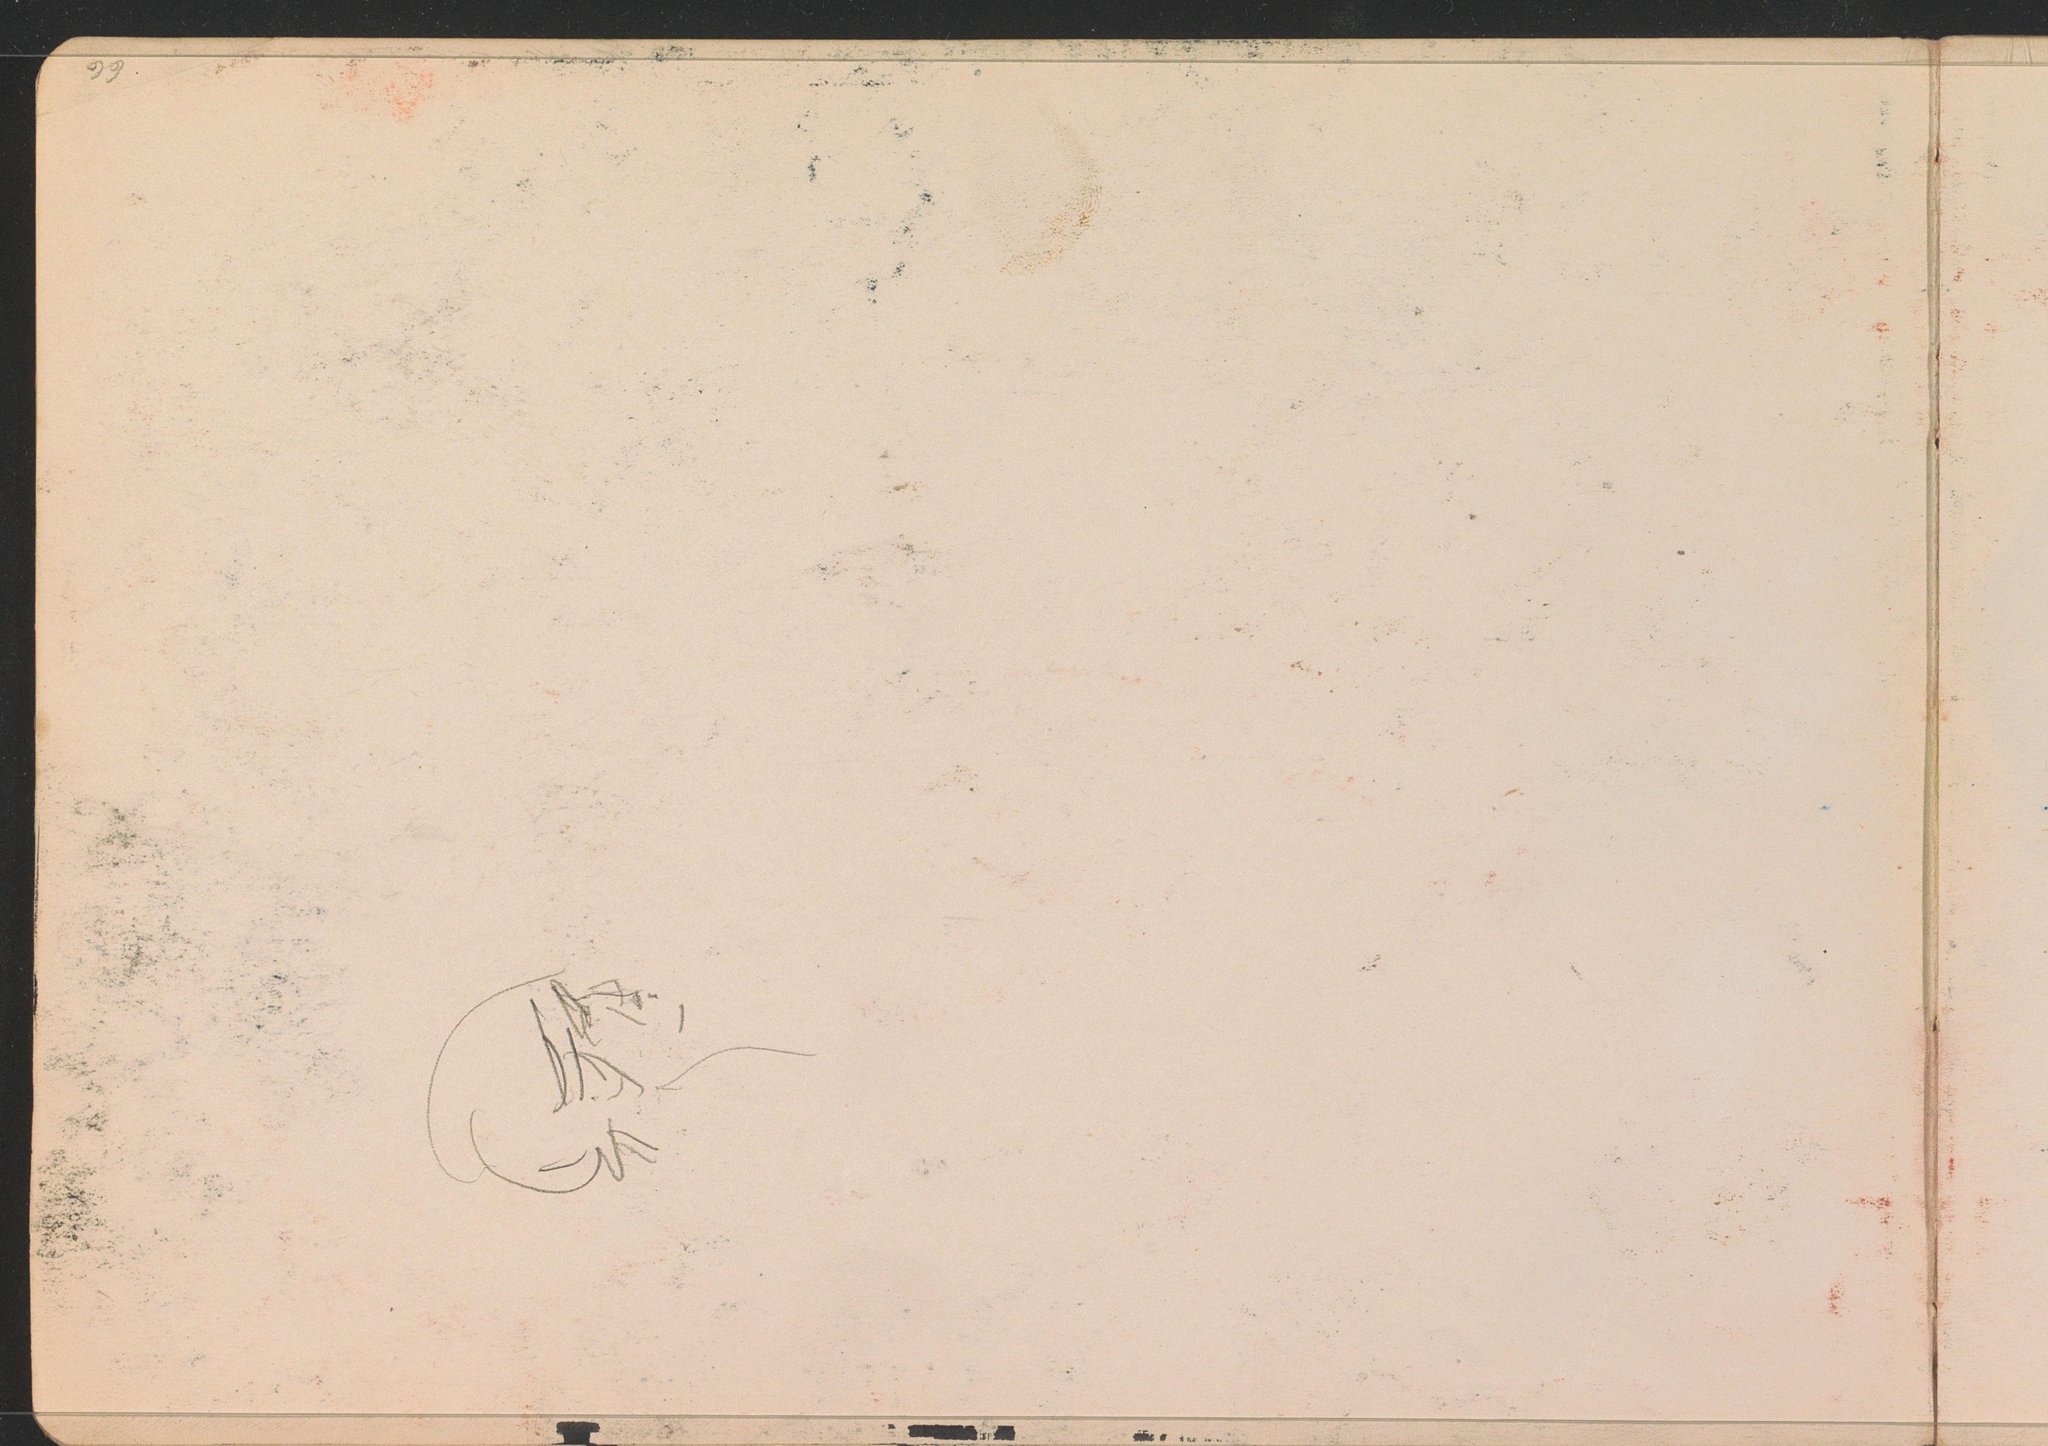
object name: sketchbook leaf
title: Hoofd, in profiel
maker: isaac israels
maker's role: draughtsman, painter, print maker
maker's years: 1865-1934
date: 1915-1934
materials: paper, pencil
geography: the hague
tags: head (human) (+ sideview, profile)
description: Blad 1 verso uit schetsboek VI met 33 bladen.